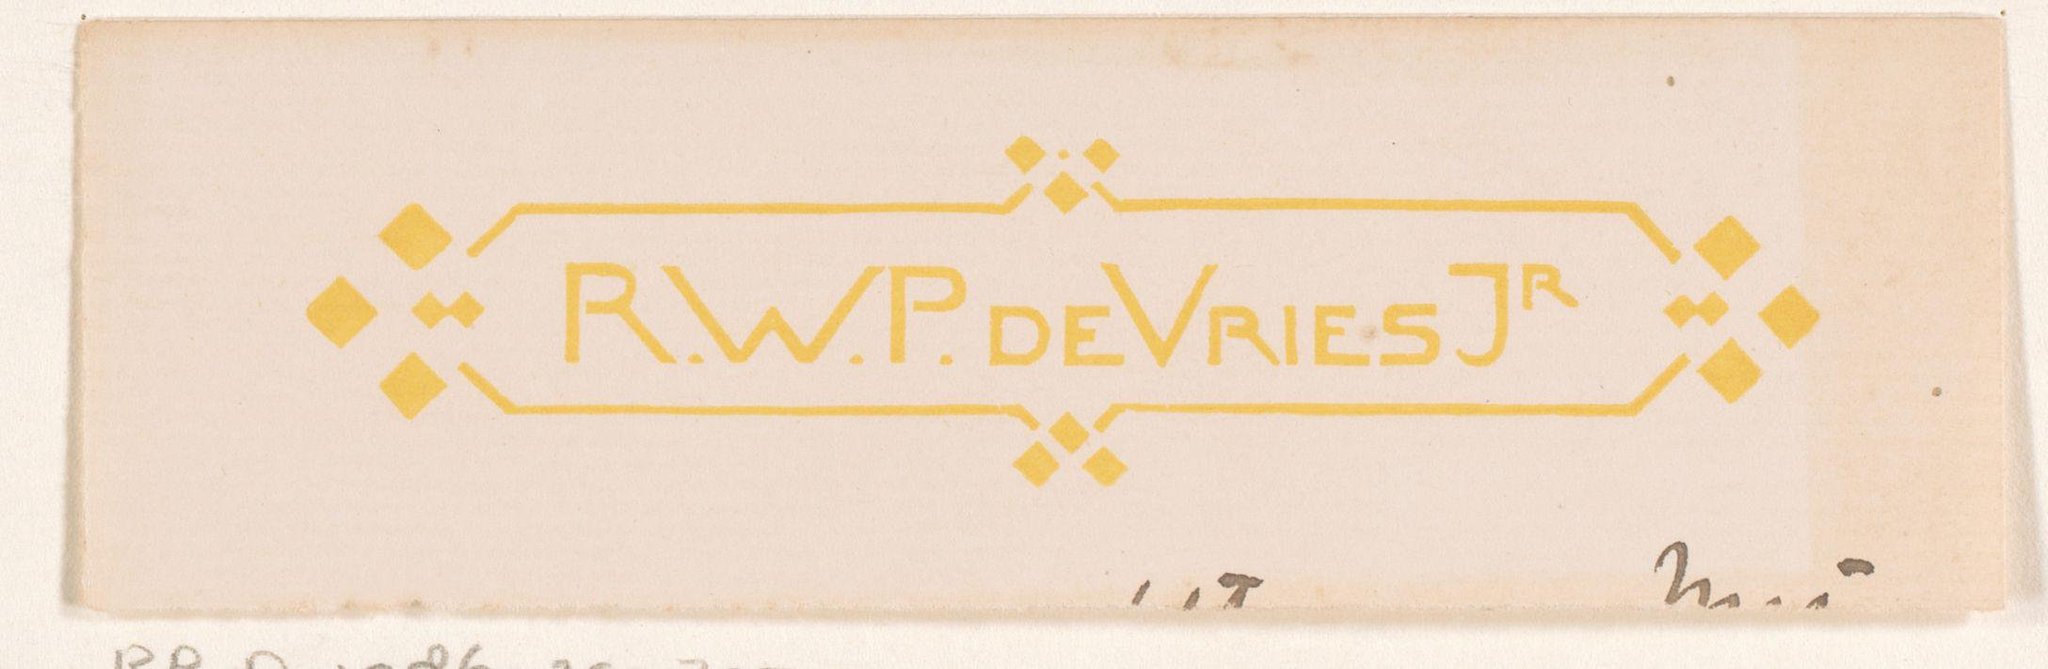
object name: photomechanical print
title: Vignet R.W.P. de Vries Jr.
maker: reinier willem petrus de vries (1874-1953)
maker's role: draughtsman, print maker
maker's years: 1874-1953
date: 1884-1952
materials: paper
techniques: printing block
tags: amsterdam, print maker, draughtsman, reinier willem petrus de vries (1874-1953)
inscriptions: collector's mark: ‘R:MVS.’